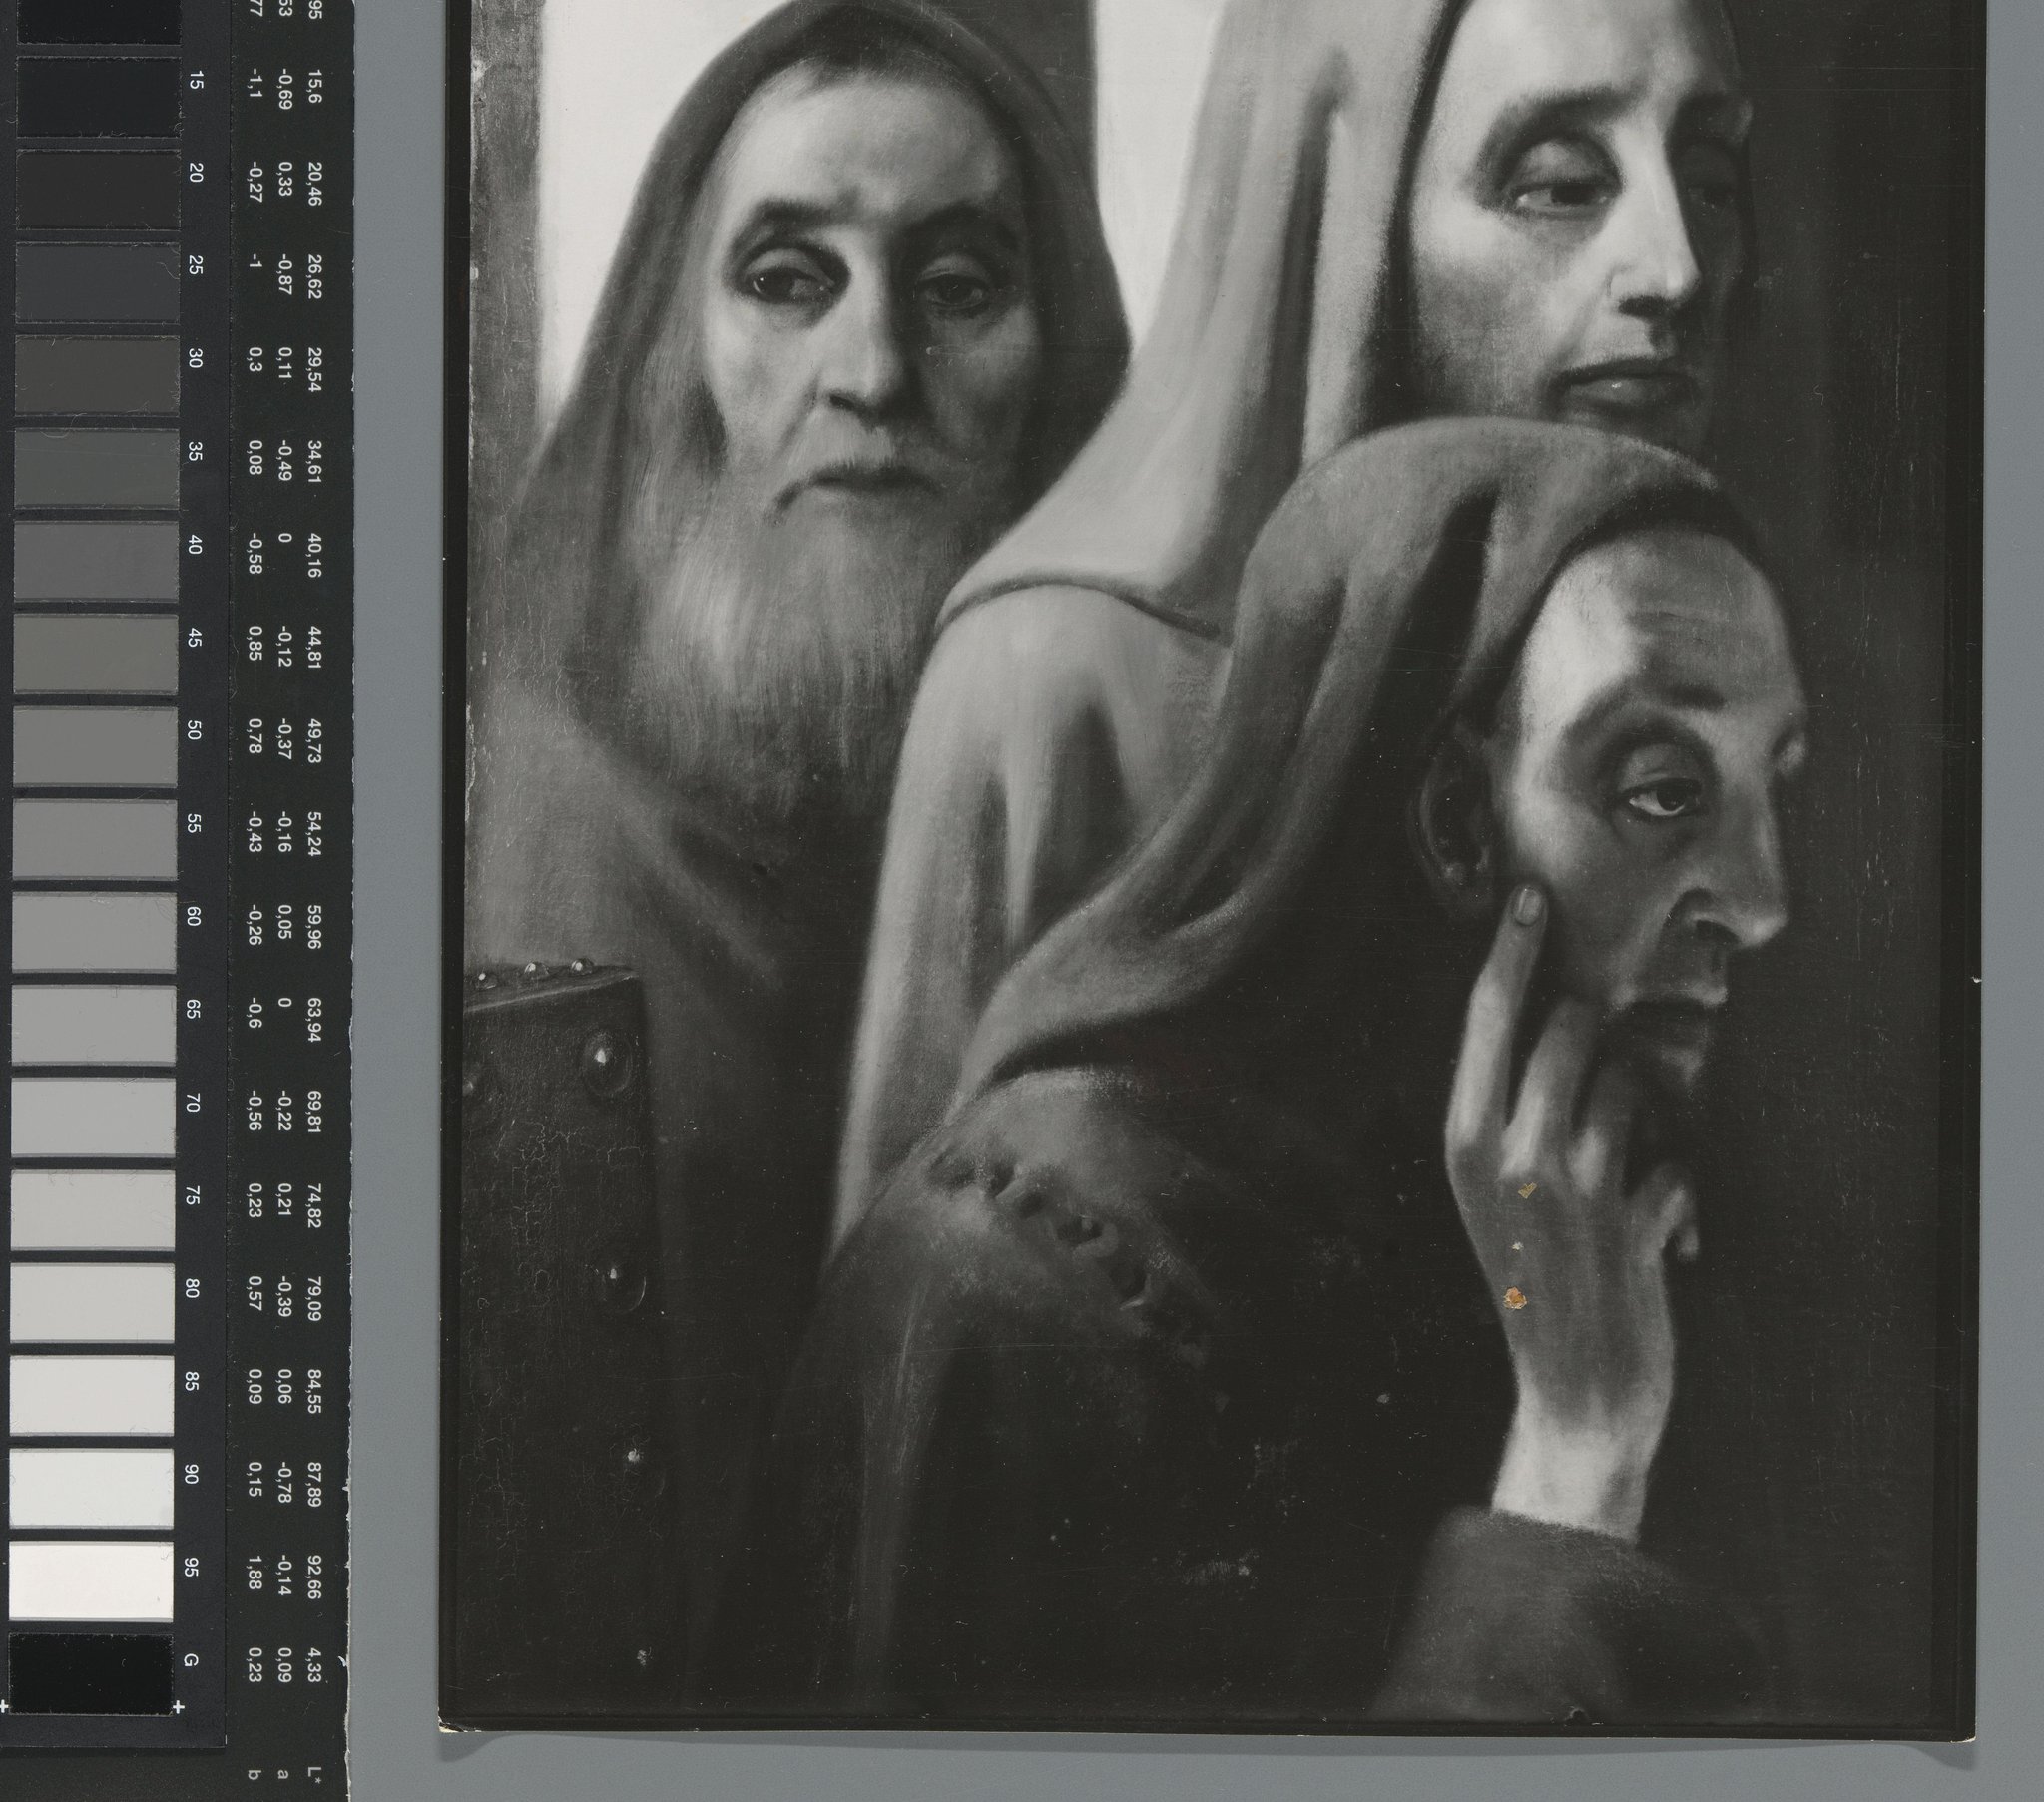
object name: photograph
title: Fotografische reproductie van een (detail) schilderij van Han van Meegeren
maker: nico zomer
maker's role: fotograaf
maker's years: 1910-1988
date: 1908-1948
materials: photographic support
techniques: gelatin silver print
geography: amsterdam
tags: picture, painting